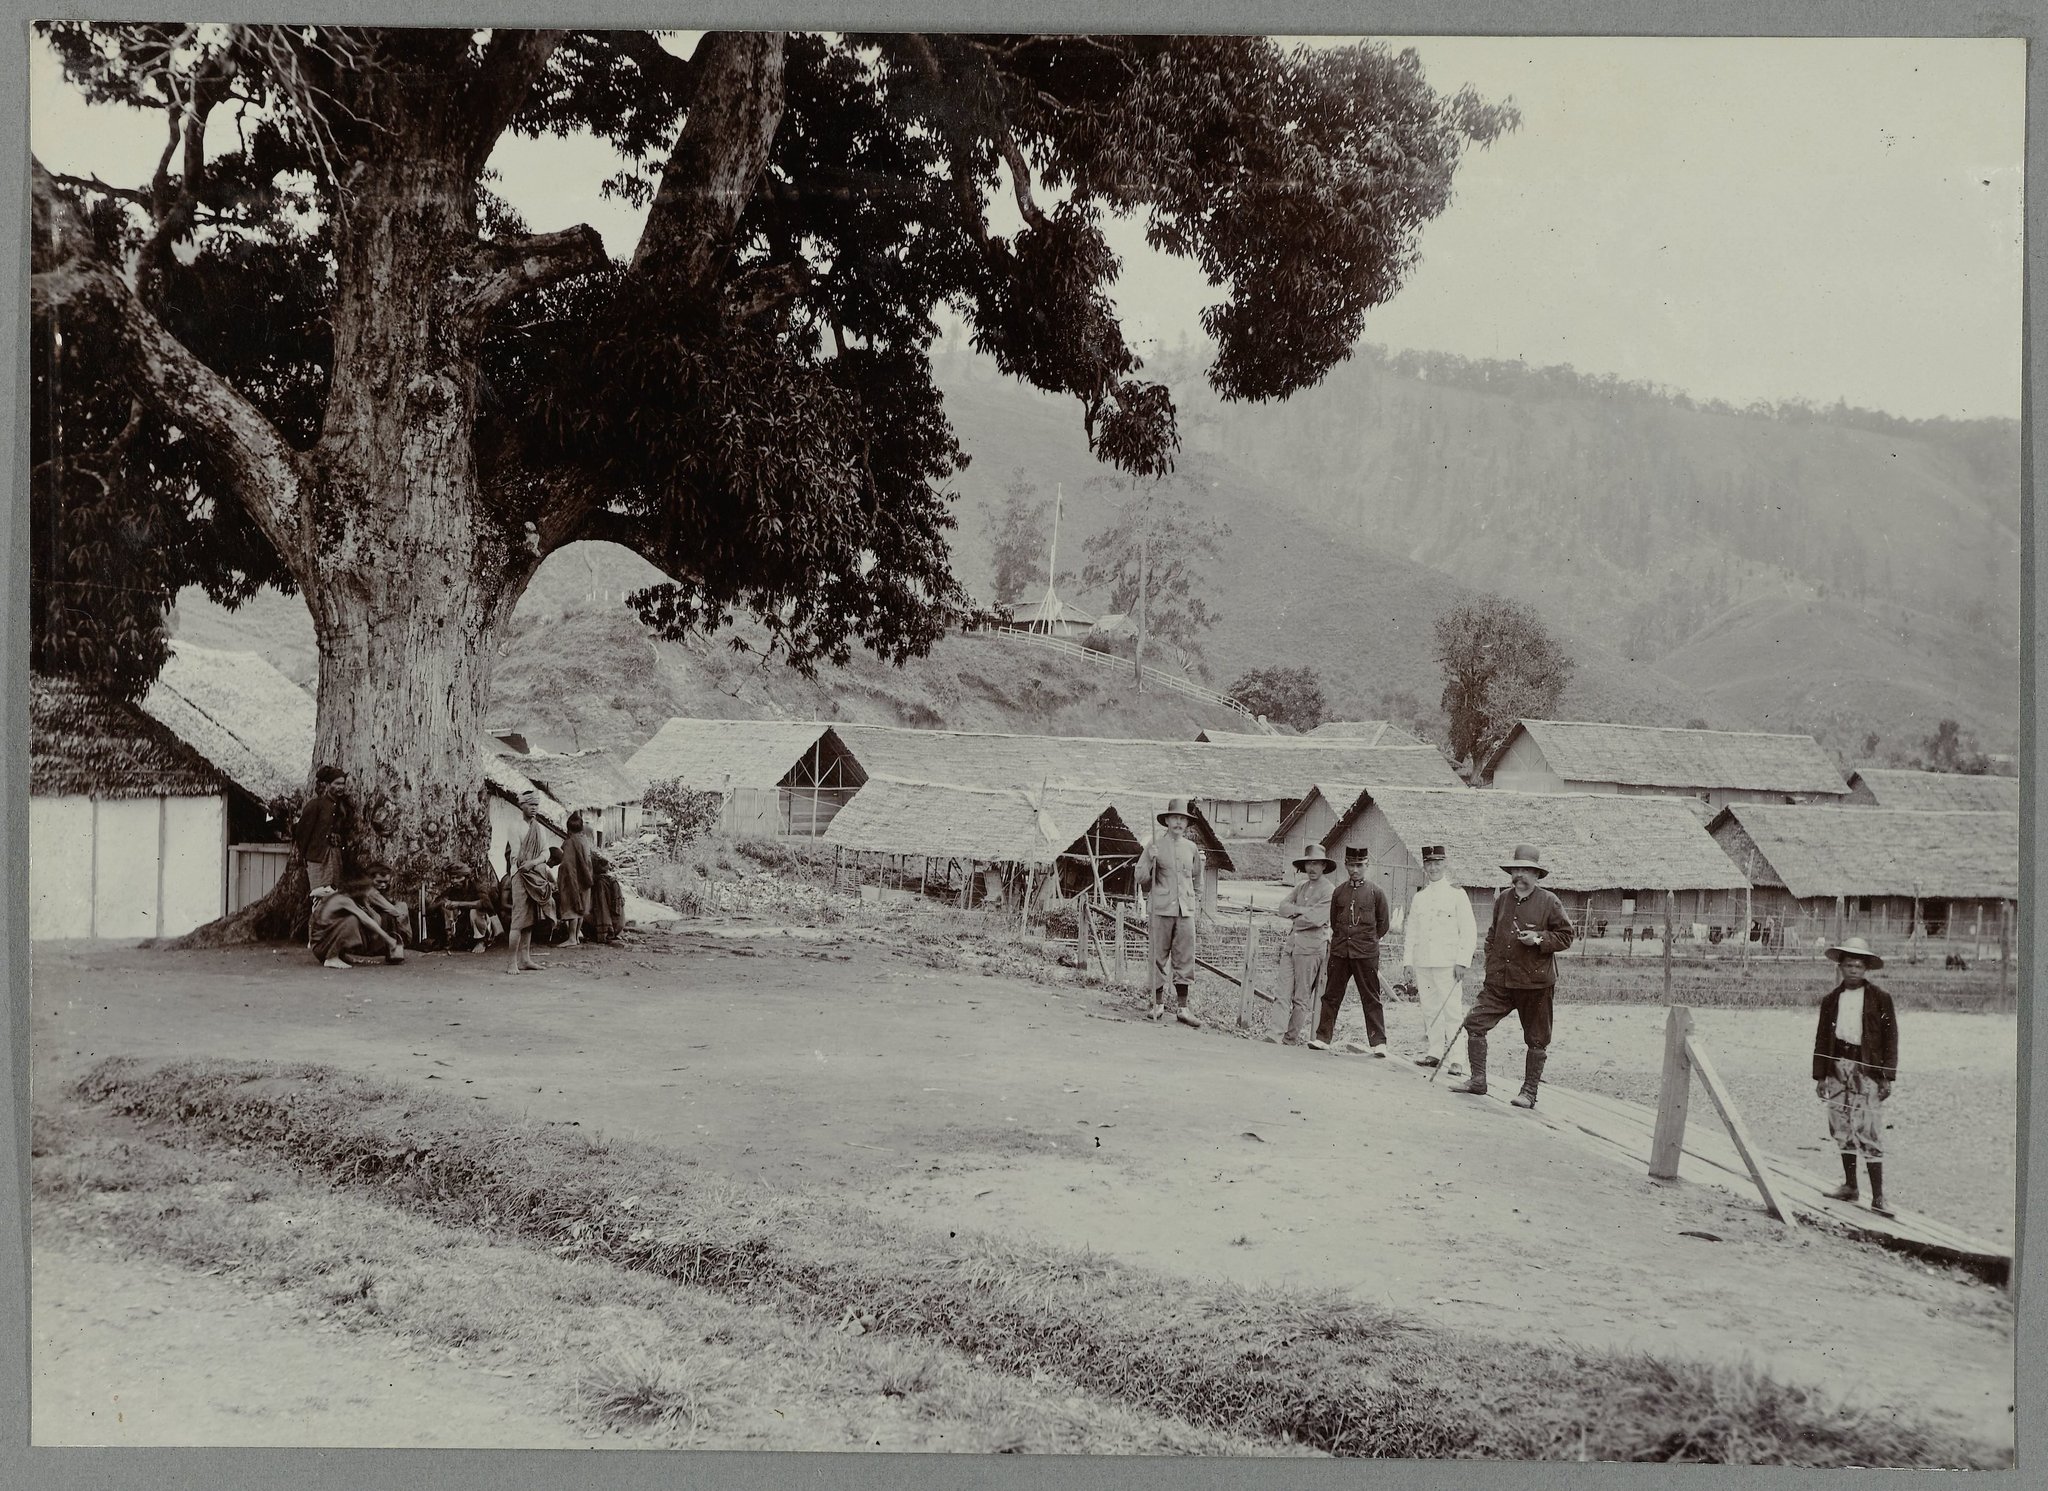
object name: photograph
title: Nederlanders aan het meer te Takinguen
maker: Anonymous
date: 1903-1913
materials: photographic support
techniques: photography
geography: north sumatra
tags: arnhem, albertus dominicus laman trip, landscapes in tropical and sub-tropical regions, lake, road, path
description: Na de expedities naar de Gajo- en Alaslanden o.l.v. Van Daalen (eerste tocht in 1901), werd hij in 1903 belast met voorbereiding van permanente vestiging van Nederlands gezag. Aanleg van een weg van de Noordkust naar het binnenland was hierbij van groot belang. Deze zgn. Gajoweg werd aangelegd tussen 1903 en 1914, van Bireuen aan de kust naar Takinguen aan het bergmeer Danau Lauttawar, totale lente 104 km.